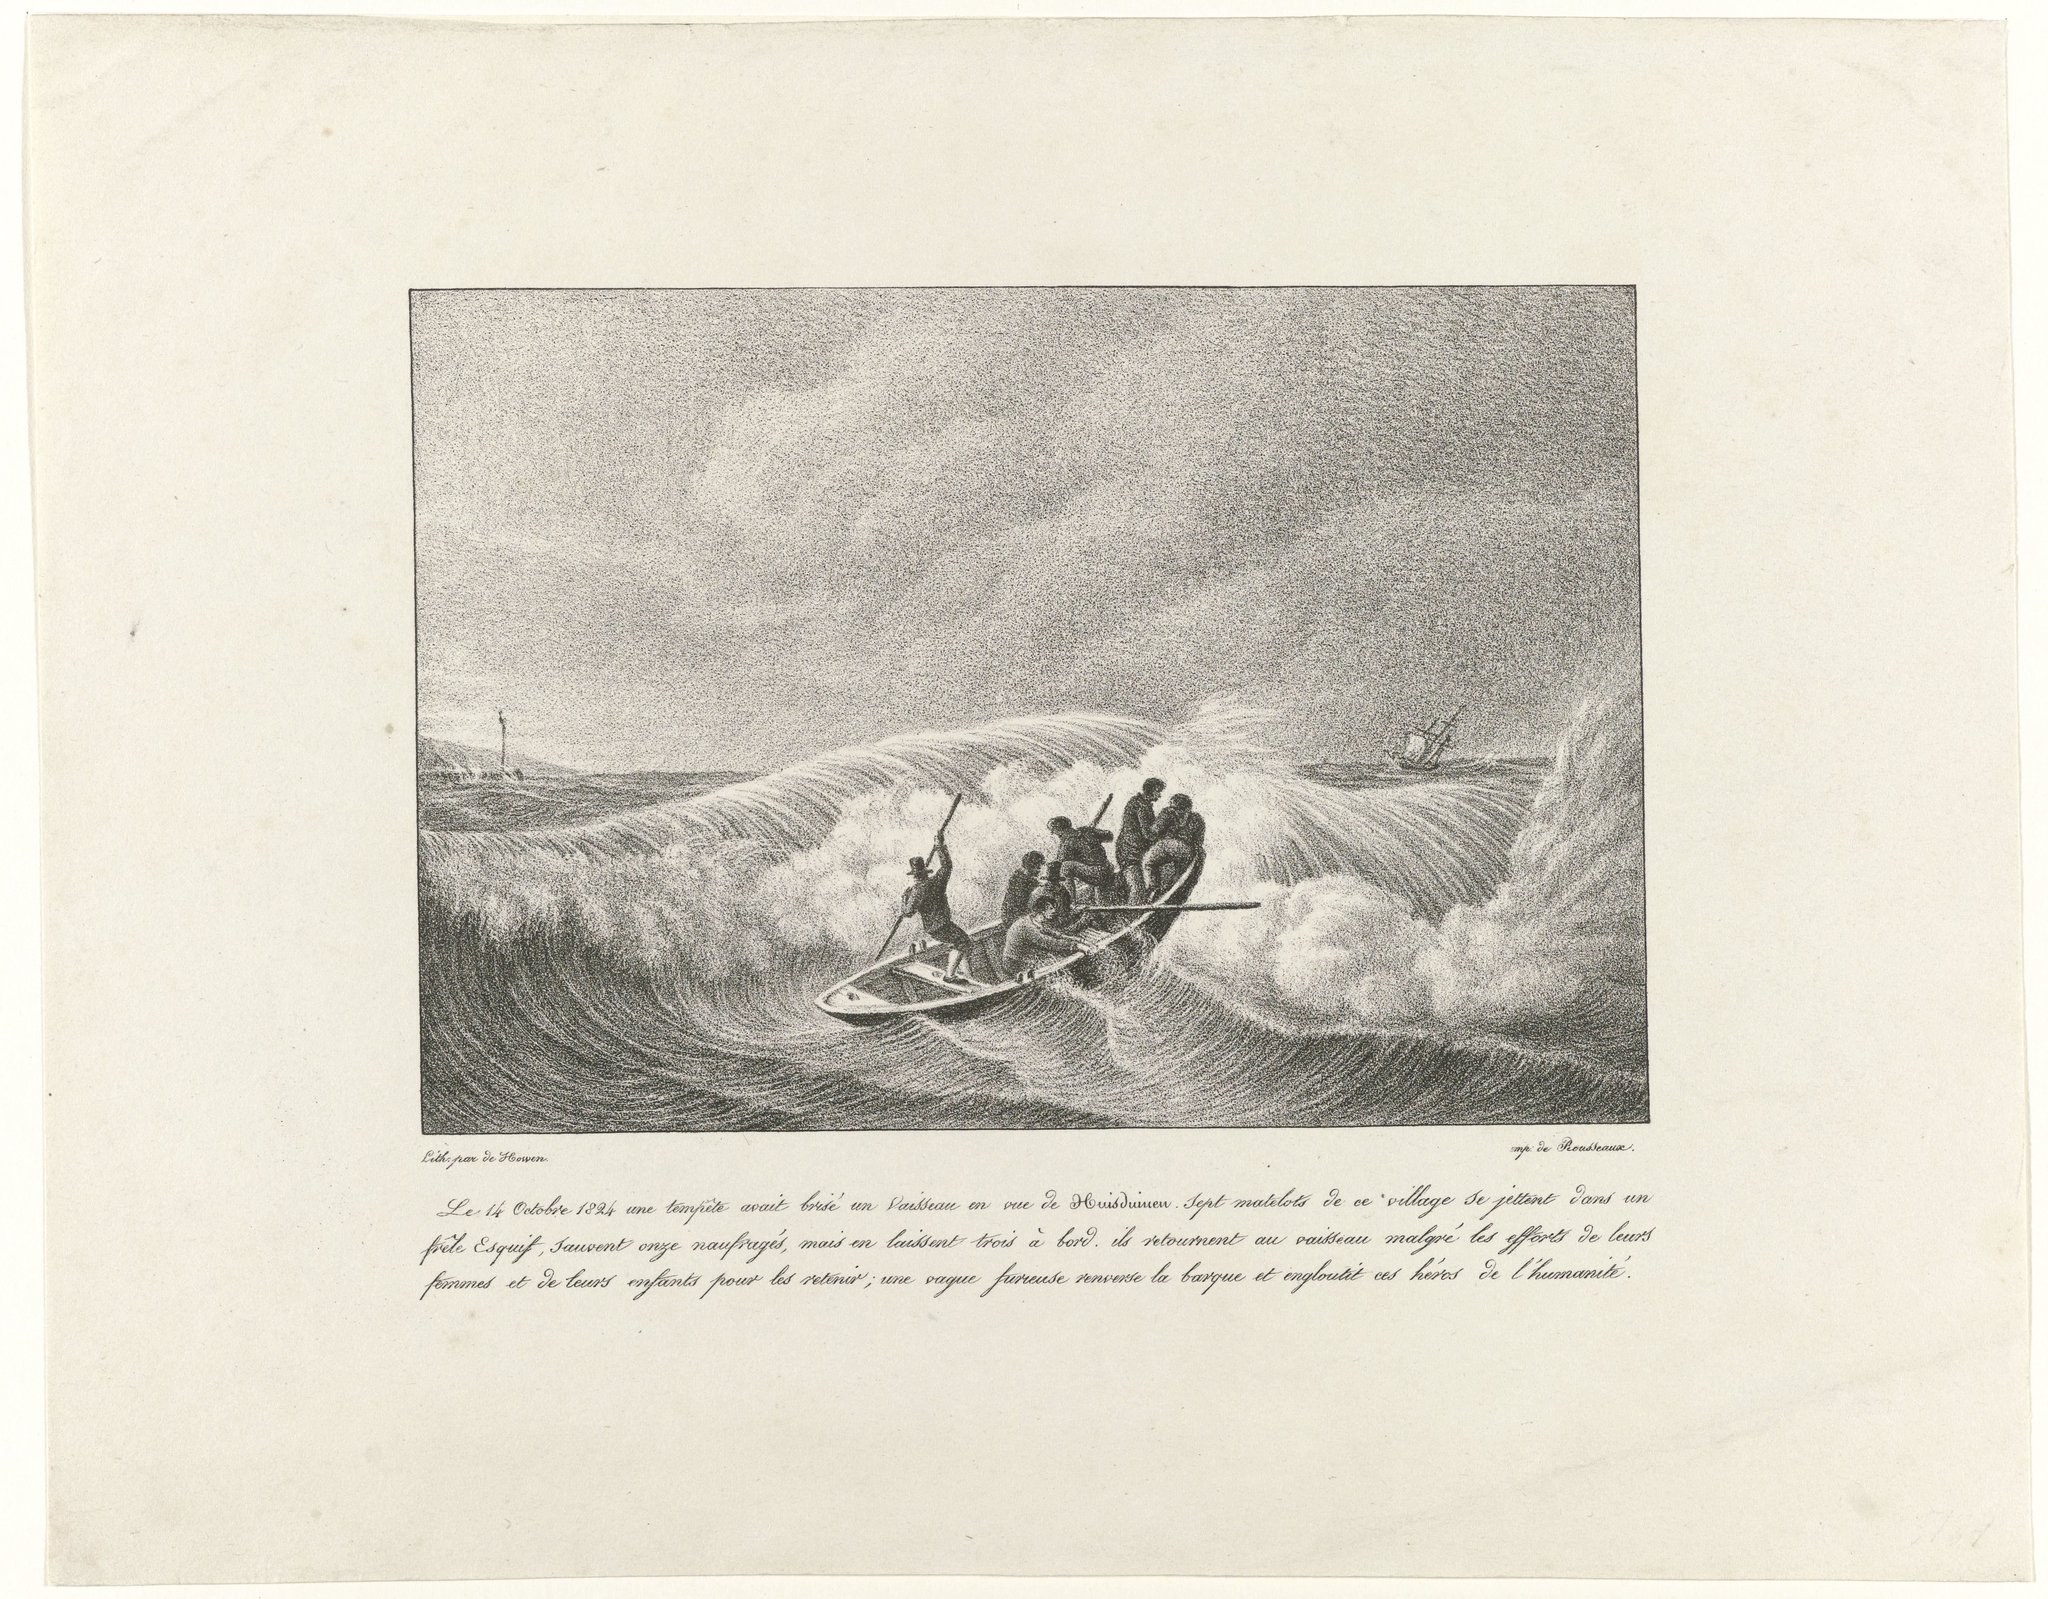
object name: print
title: Schipbreuk van de zeven matrozen uit Huisduinen, 1824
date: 1824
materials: paper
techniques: lithograph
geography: netherlands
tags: shipwreck, storm at sea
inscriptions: collector's mark: Lugt 2228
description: Tragische schipbreuk van de zeven matrozen uit Huisduinen die na met hun bootje elf schipbreukelingen te hebben gered, zelf omkomen bij hun tweede poging om meer schipbreukelingen te redden, 14 oktober 1824. De sloep met de zeven mannen op zee tussen hoge golven.